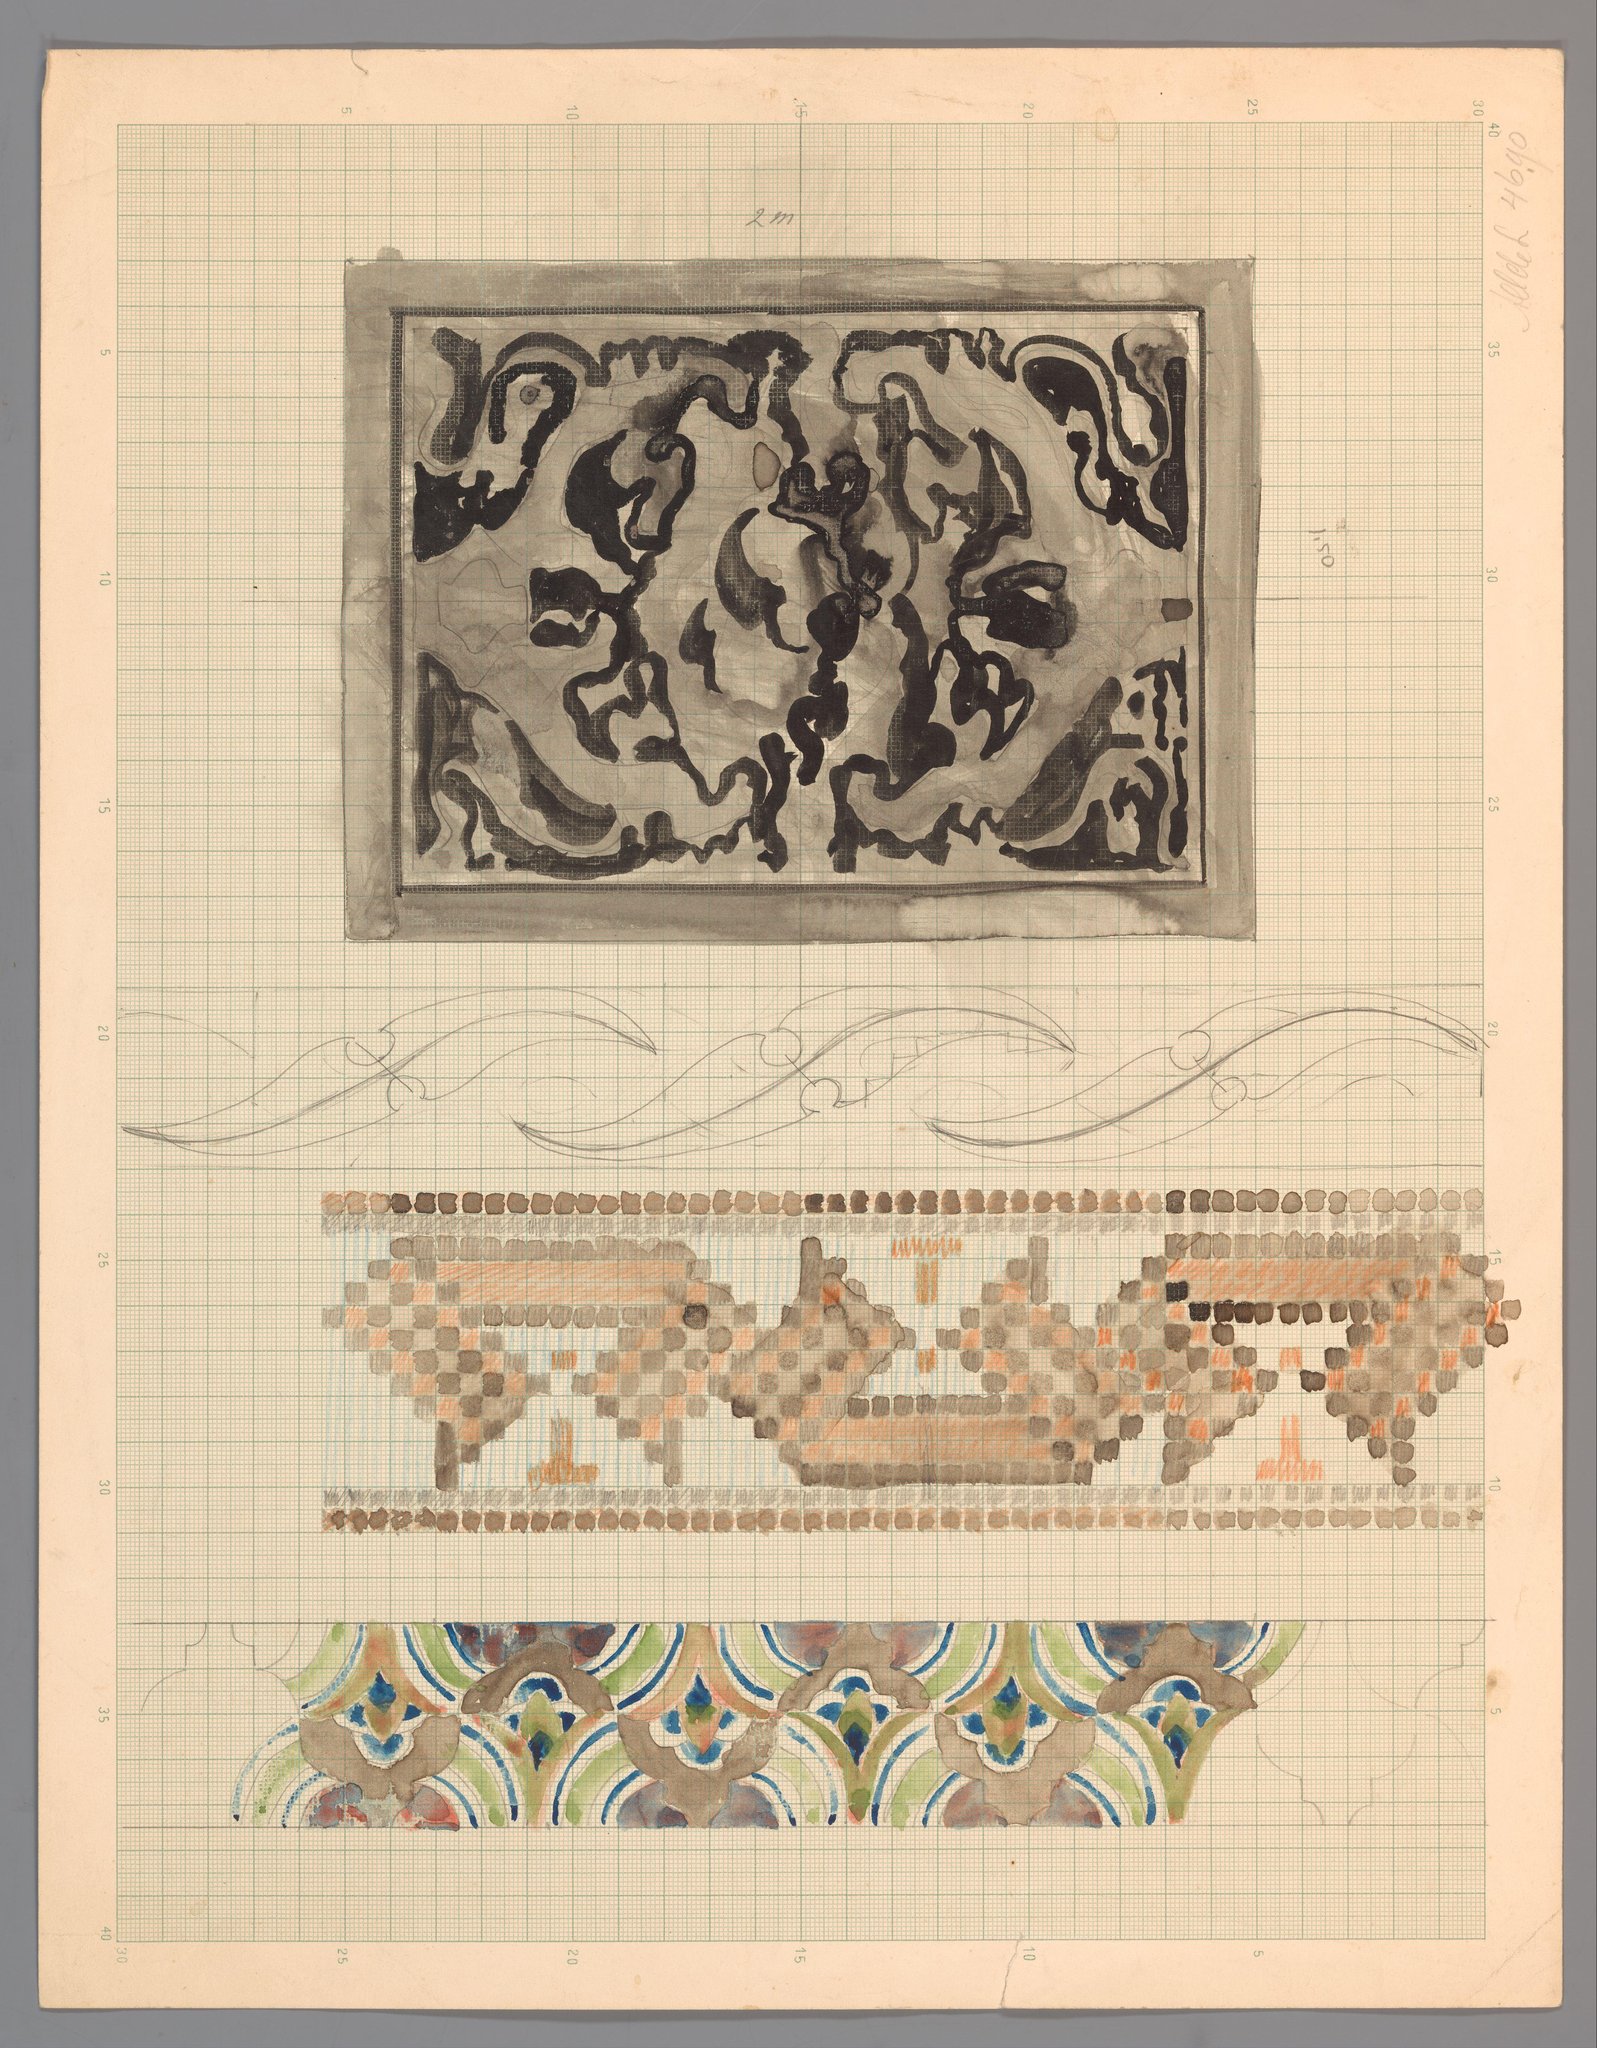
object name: design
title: Ontwerp voor een ex libris met monogram CWL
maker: carel adolph lion cachet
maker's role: draughtsman, print maker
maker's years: 1864-1945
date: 1874-1945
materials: chalk, paper, pencil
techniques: brush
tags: ex-libris